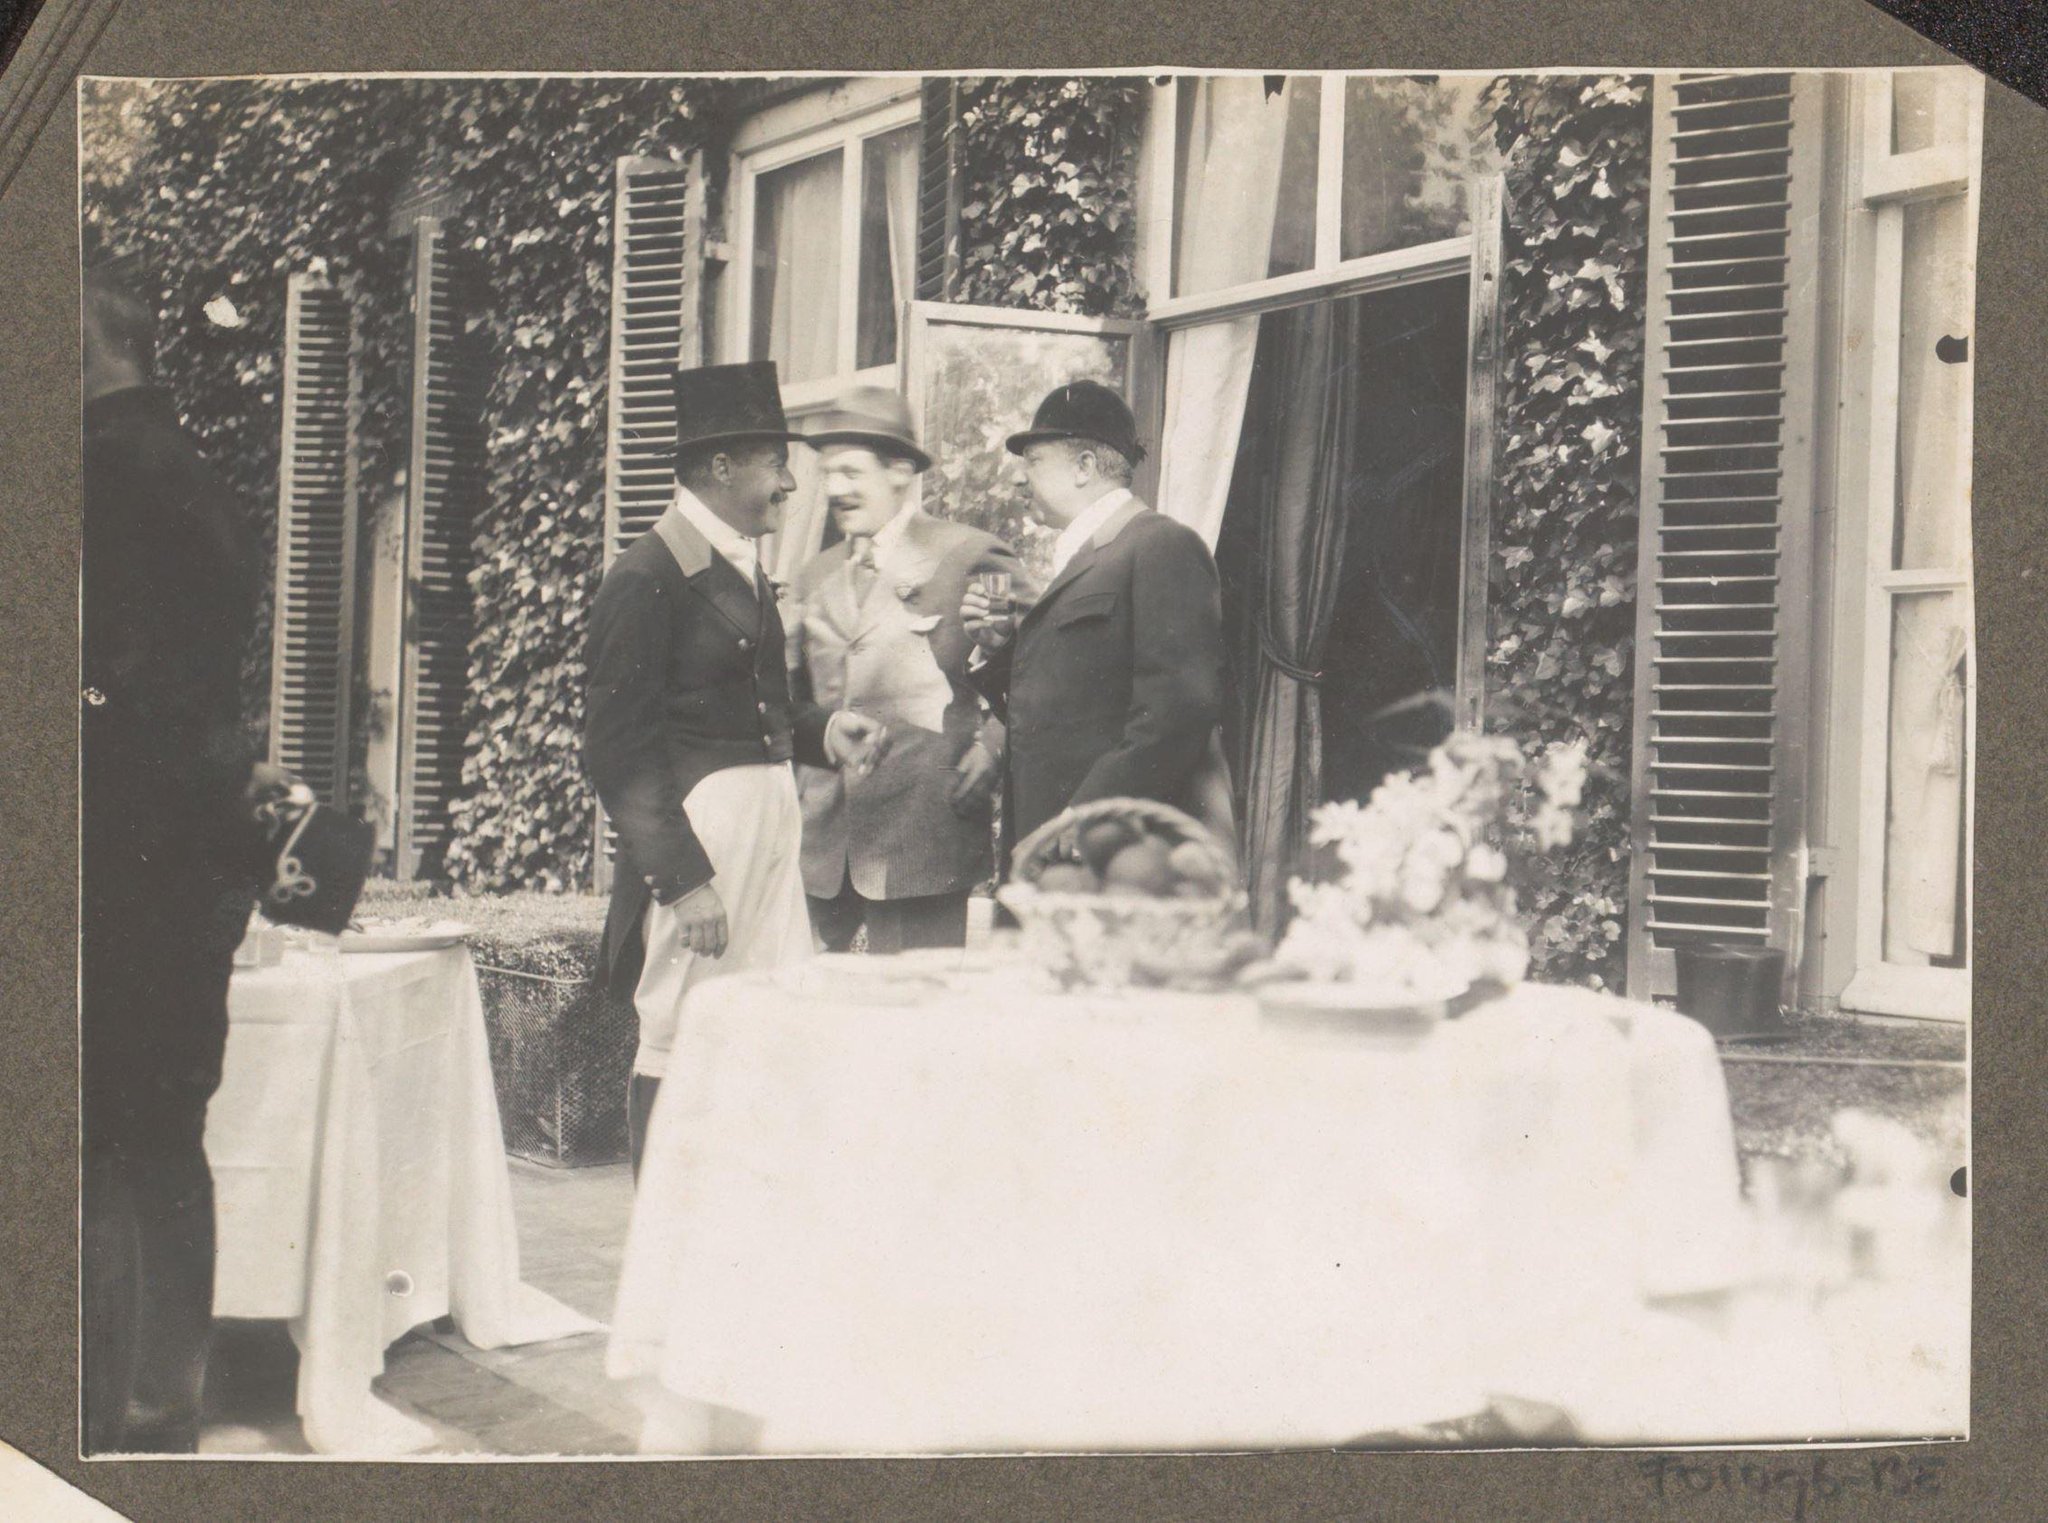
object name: album leaf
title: Ruitertafereel op Koninklijke Houtvesterij Het Loo: gezelschap bij gedekte tafels bij een landhuis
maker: Anonymous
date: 1900-1925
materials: photographic support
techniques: gelatin silver print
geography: het loo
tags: hunting, chase, hunting-ground, rural housing, e.g. country-house, villa, cottage, eating and drinking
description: Onderdeel van Fotoalbum van de heer Brams, opperhoutvester van koningin Wilhelmina op Koninklijke Houtvesterij Het Loo.